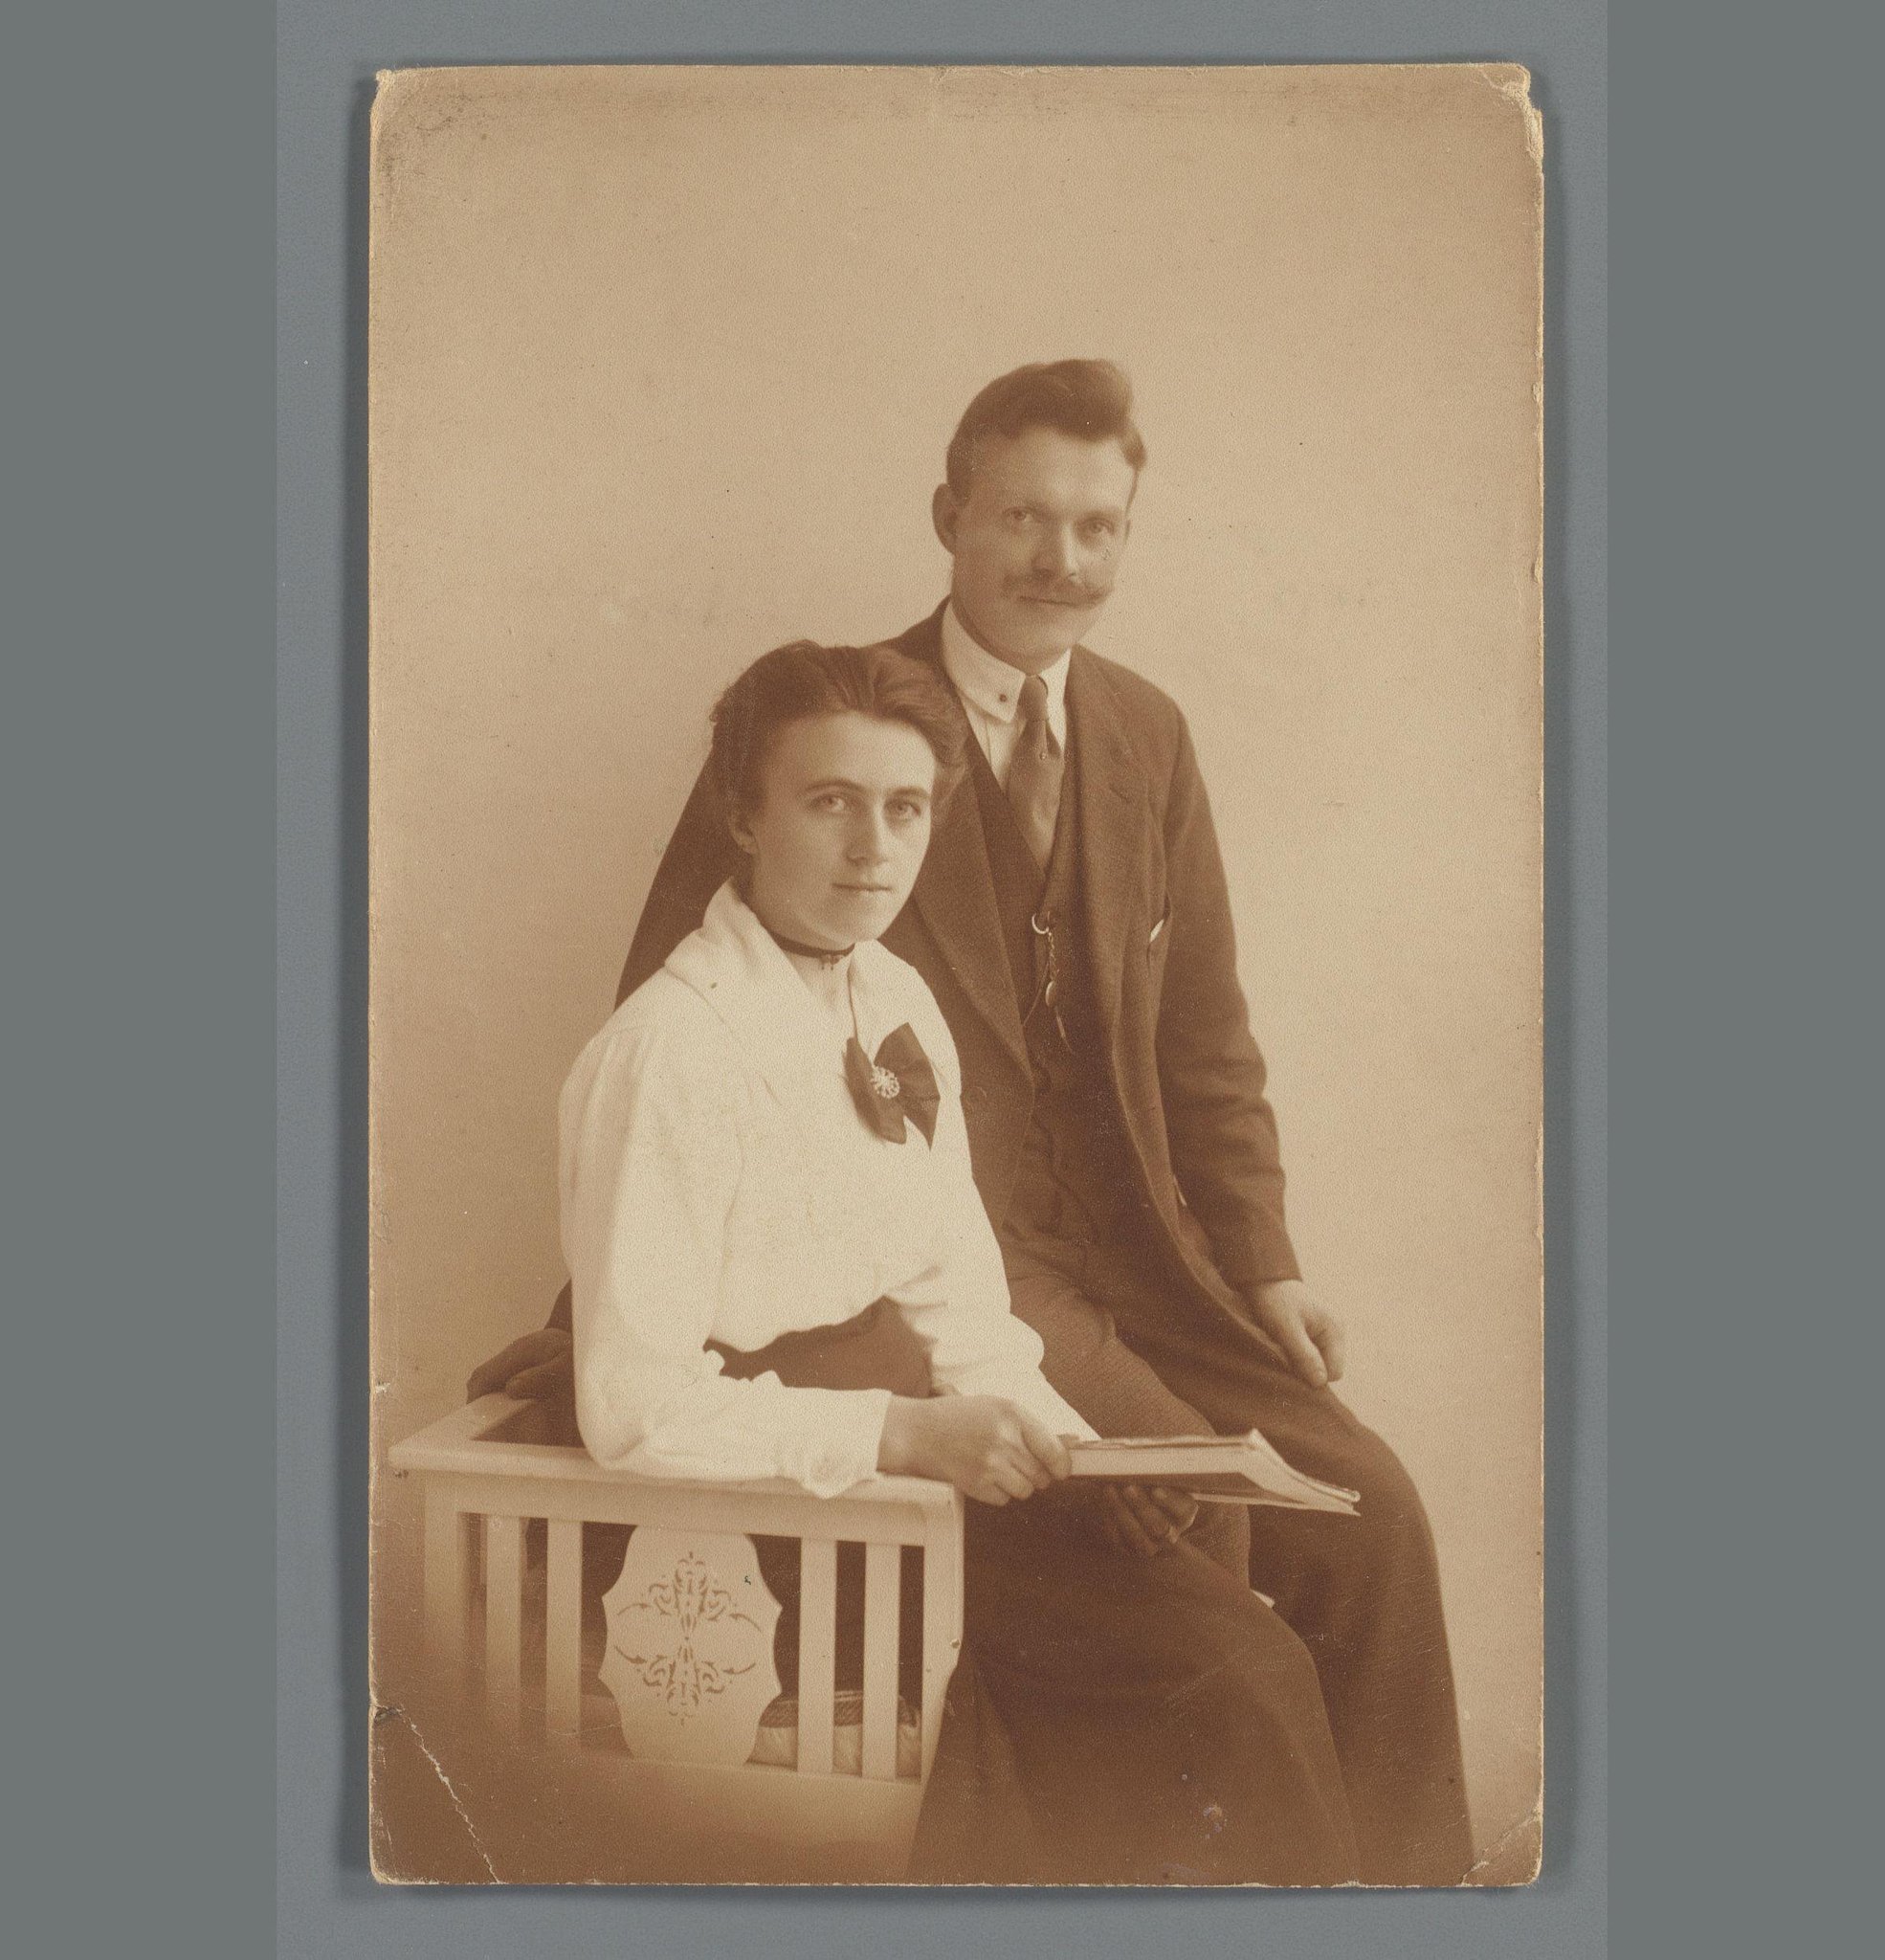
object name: ansichtkaart, prentbriefkaart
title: Portret van Griet en Dirk Meijer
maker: Anonymous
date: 1905-1920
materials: paper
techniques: gelatin silver print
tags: historical persons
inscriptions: inscription: ‘griet en dirk/ Meijer’